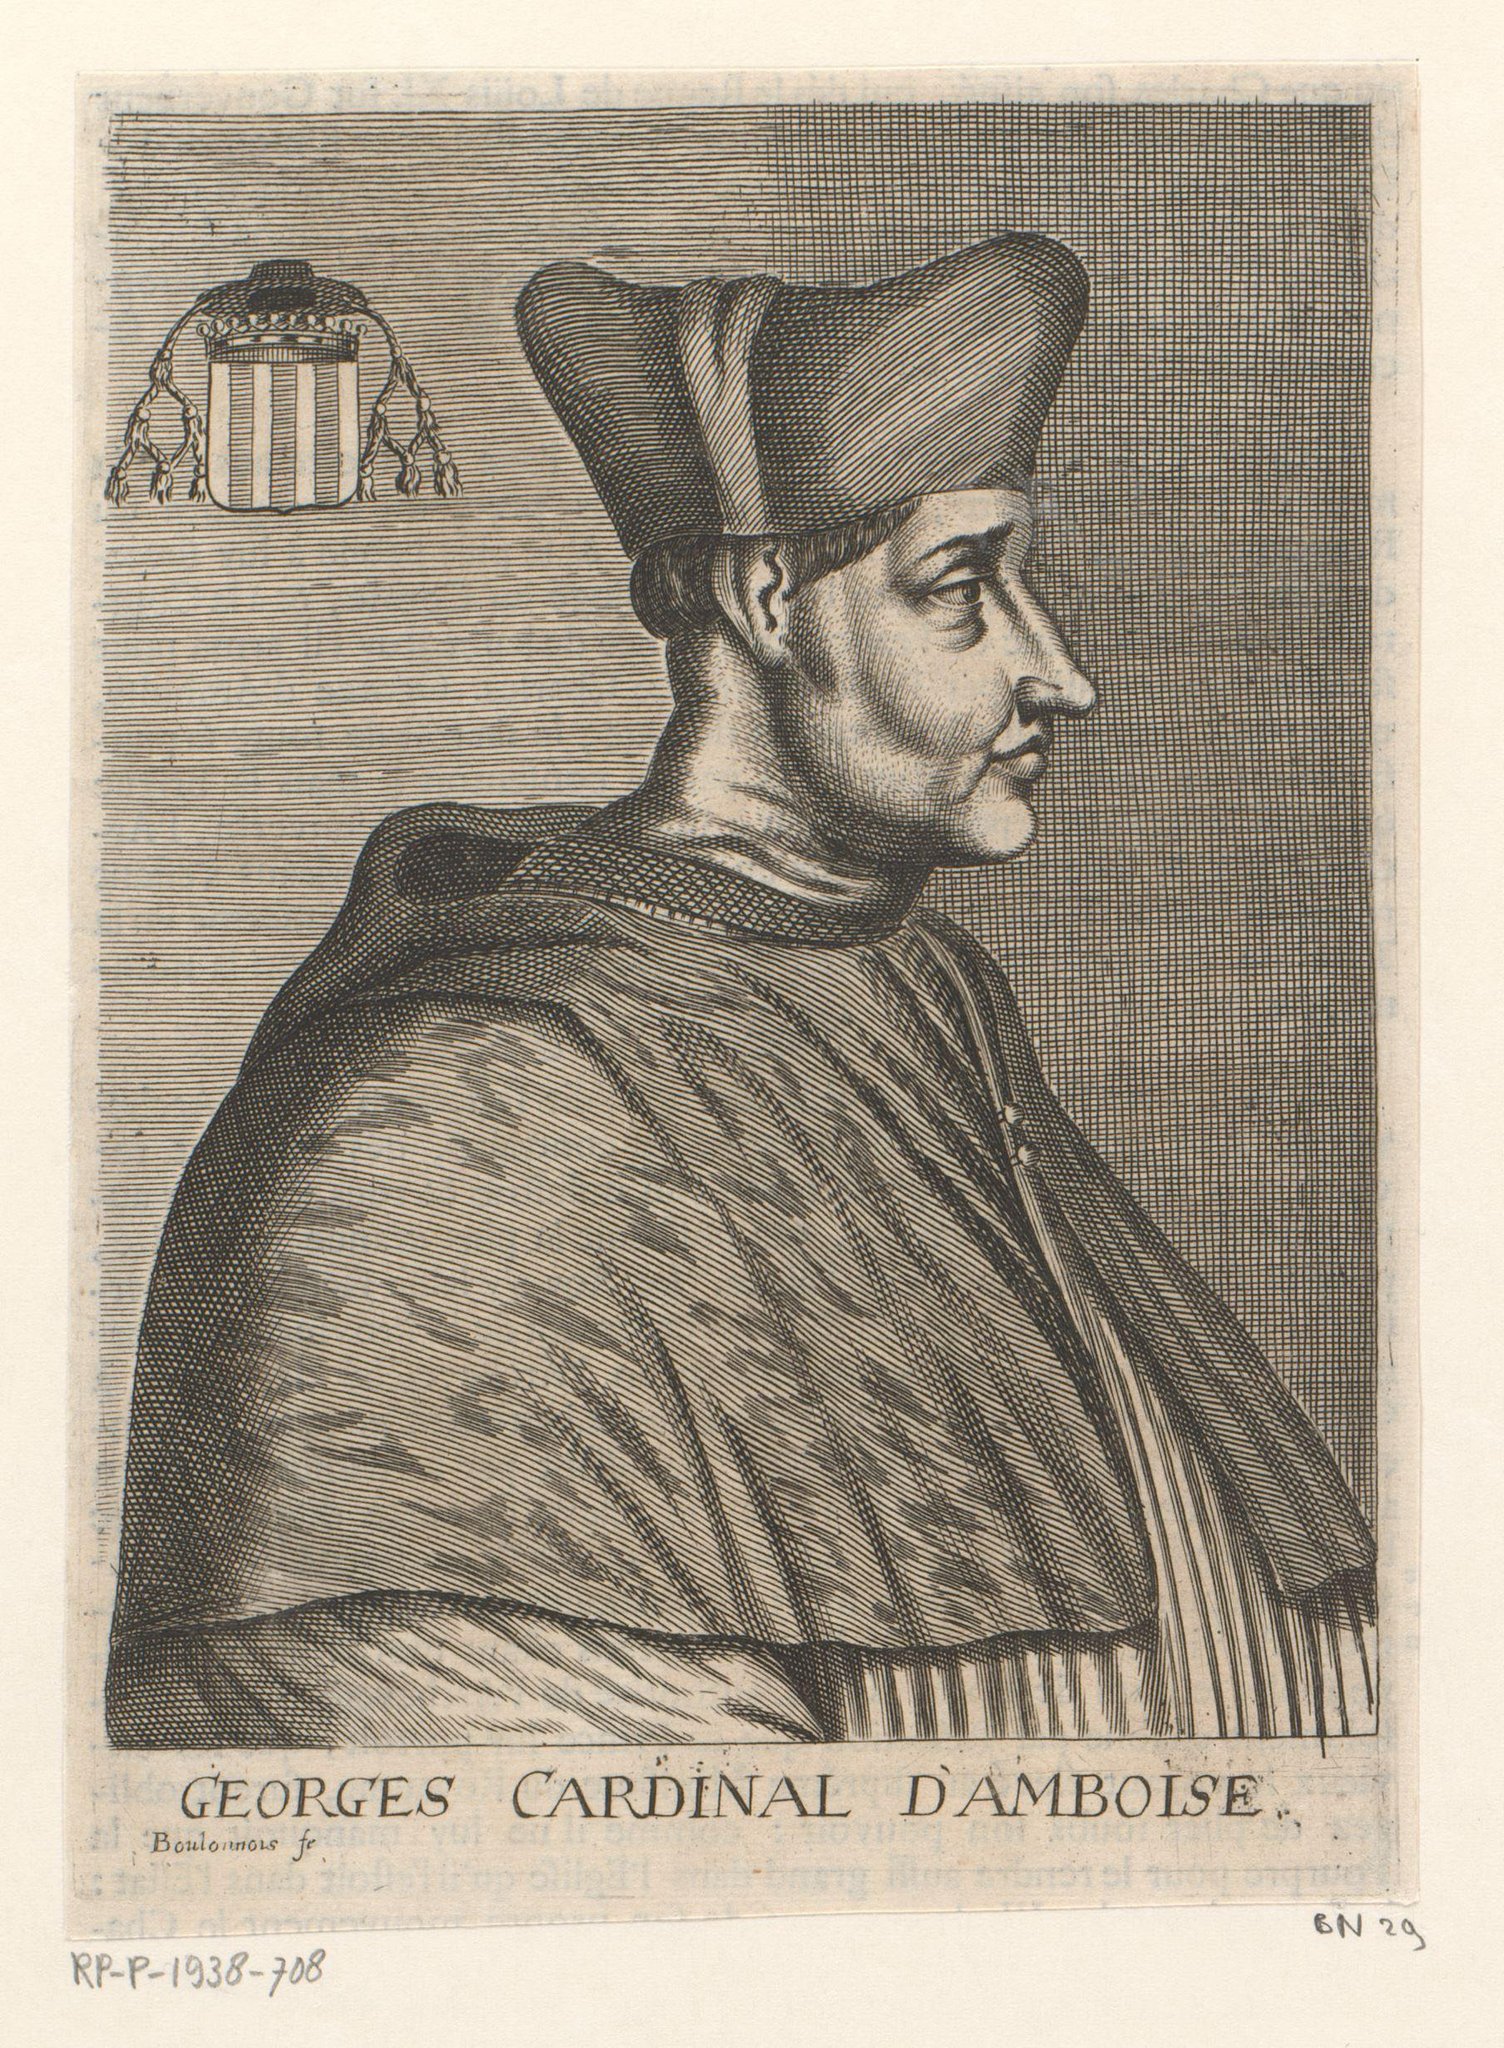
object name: book illustration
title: Georges Cardinal d'Amboise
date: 1682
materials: paper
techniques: engraving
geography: brussels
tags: cardinal, historical persons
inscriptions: collector's mark: Lugt 2228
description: Prent uit: Bullert, Isaac. Académie des Sciences et Arts contenant les vies et éloges his. des hommes illustres qui ont excellé en ces professions depuis environ quatre siècles. Brussel: Foppens, François, 1682. Het boek werd in 1682 eveneens in Amsterdam uitgegeven door de erfgenamen van Daniel Elzevier. Deze portretten dienen ter illustratie van de biografie van een kunstenaar of geleerde. De meeste portretten werden door Nicolas de Larmessin vervaardigd (162), 93 door De Boulonois en een derde door ongeïdentificeerde prentmakers. Dit betreft een illustratie op p. 13, deel I.